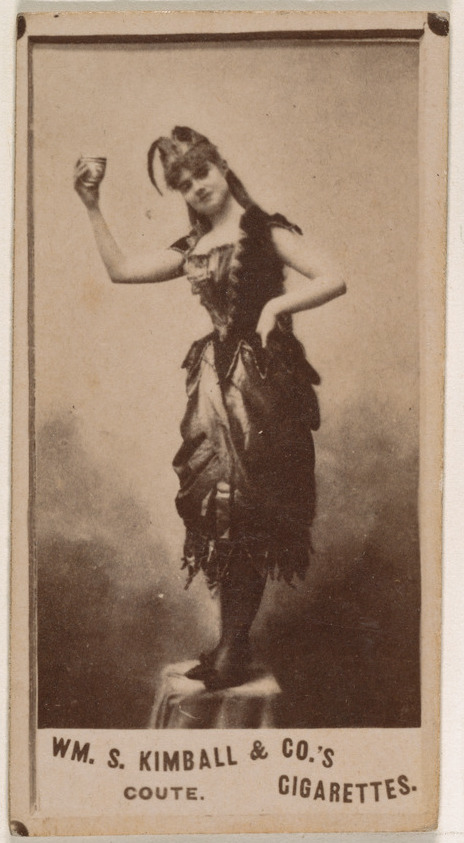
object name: photograph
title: Miss Coute, from the Actresses series (N203) issued by Wm. S. Kimball & Co.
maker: william s. kimball & company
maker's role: publisher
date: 1889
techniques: color lithograph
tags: portraits,women,actresses